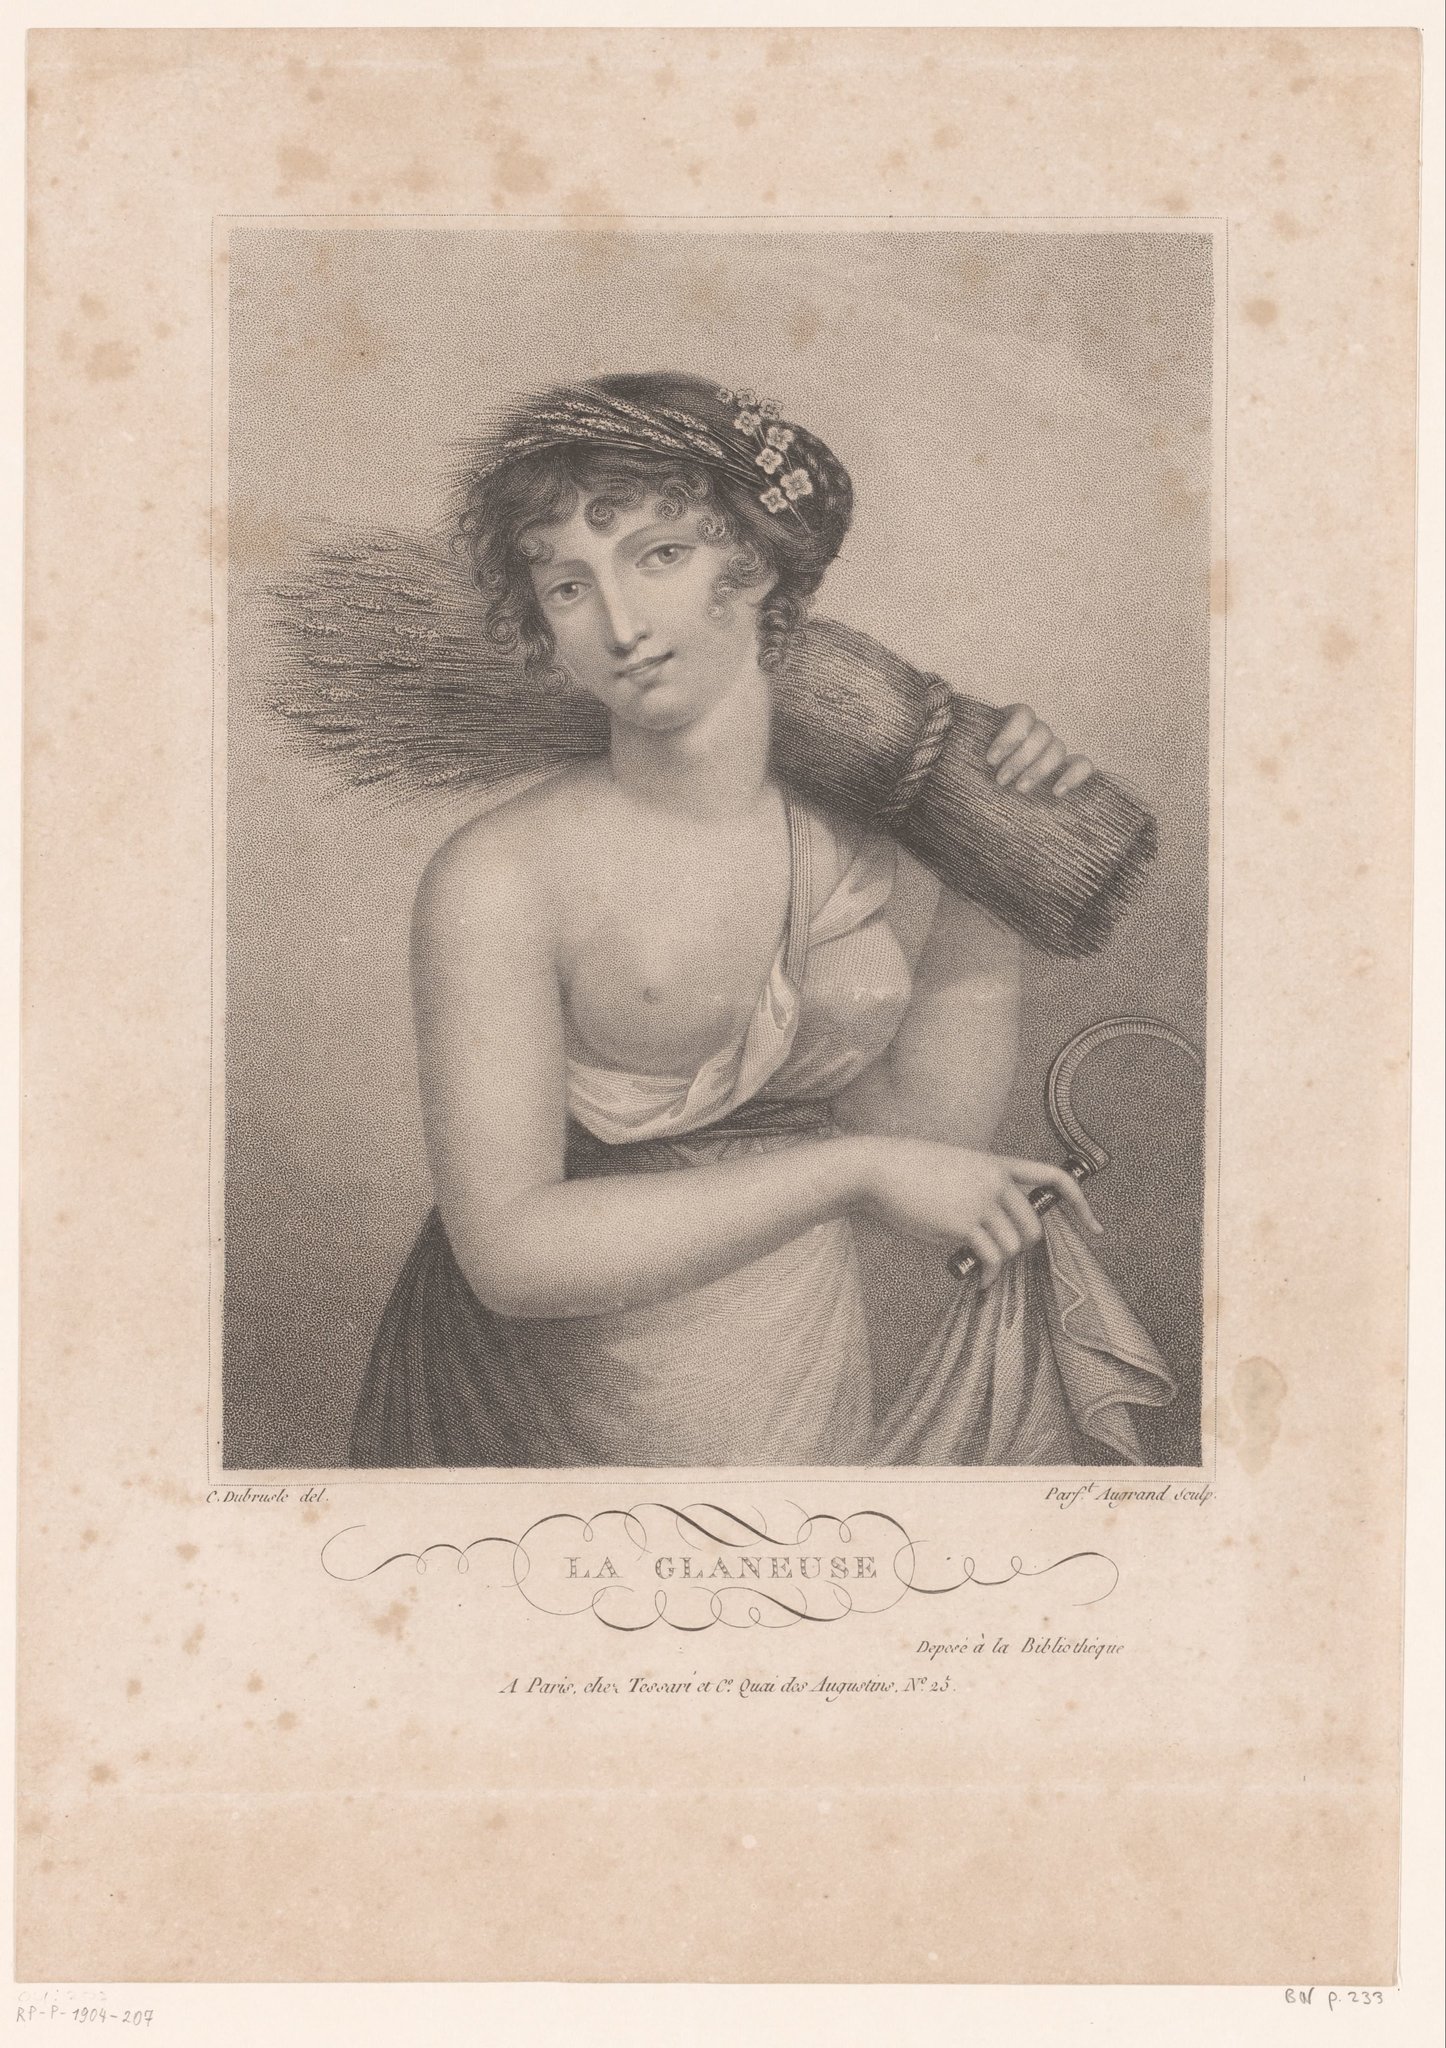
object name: print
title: Arenleesster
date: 1792-1801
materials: paper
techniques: etching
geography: paris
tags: gleaning, agricultural implements: sickle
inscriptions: collector's mark: Lugt 2228